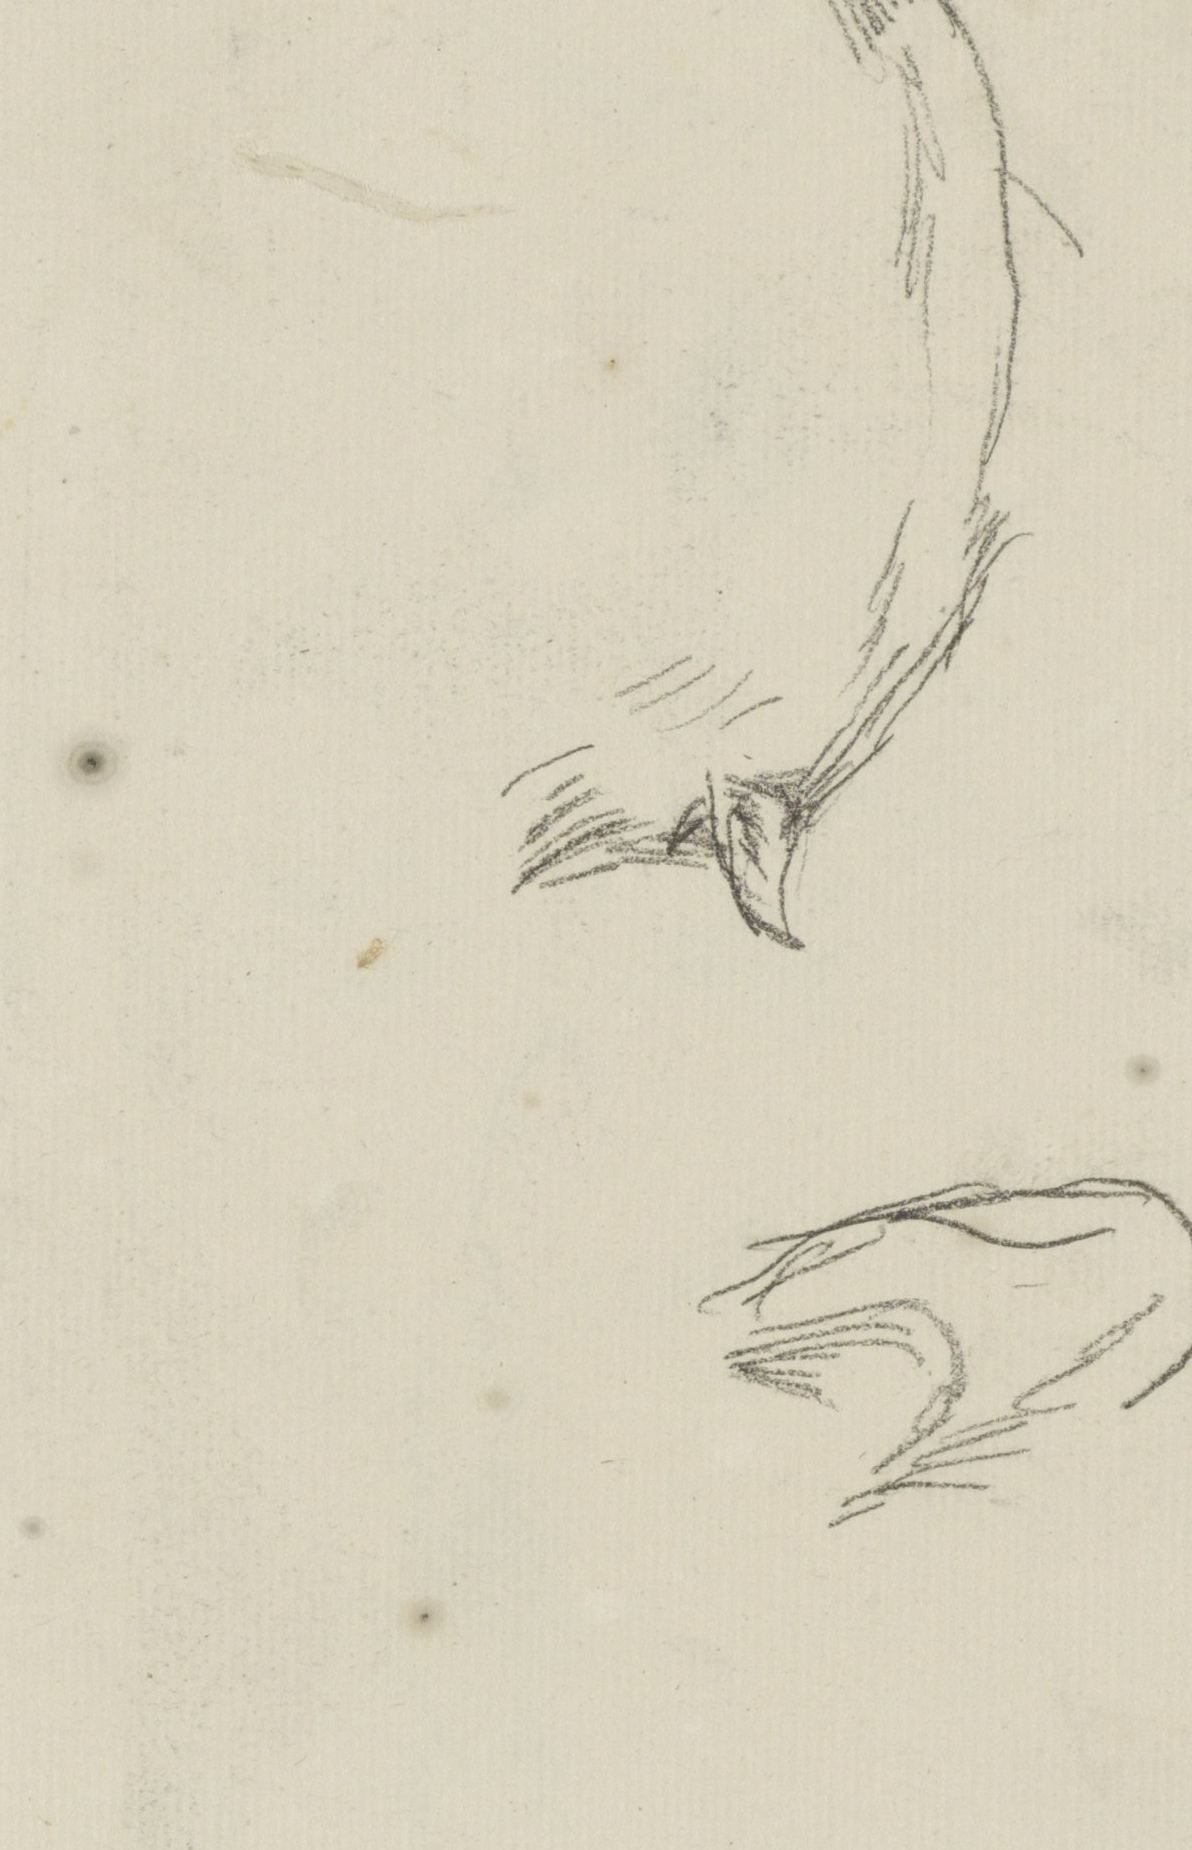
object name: sketchbook leaf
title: Twee studies van een wild zwijn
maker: george hendrik breitner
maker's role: draughtsman, painter, print maker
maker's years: 1857-1923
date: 1880-1882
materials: chalk, paper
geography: scheveningen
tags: hoofed animals: boar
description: Pagina 58 uit een schetsboek met 31 bladen.